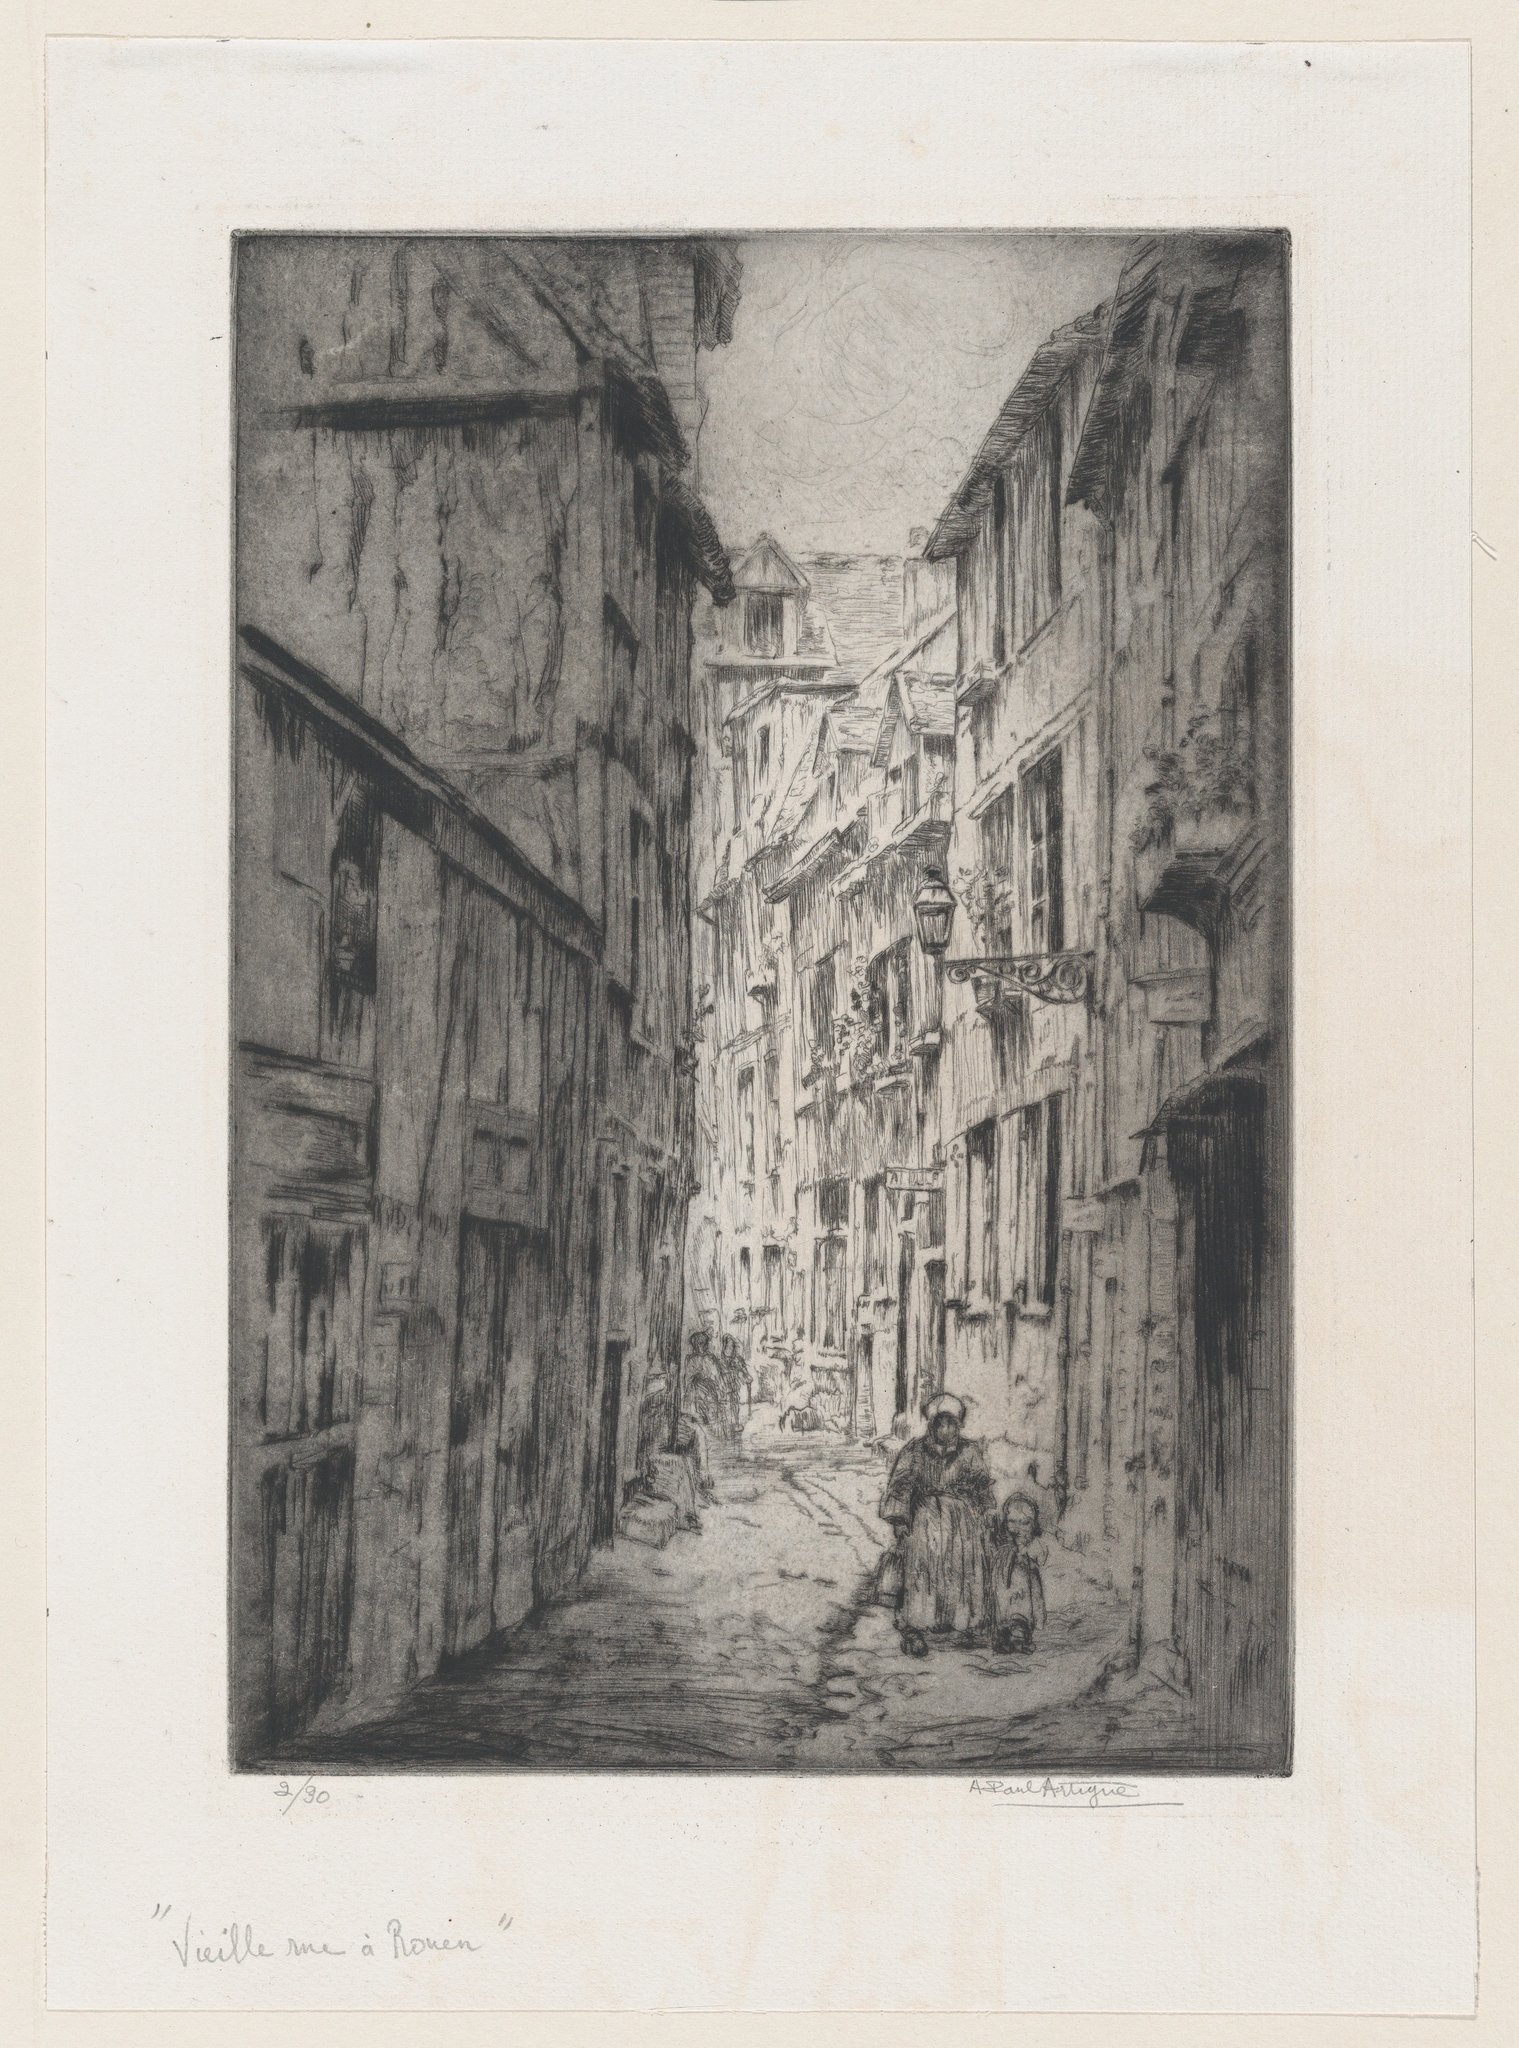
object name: print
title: Old Street in Rouen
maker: a. paul artigue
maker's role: artist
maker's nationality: french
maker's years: 1800-1900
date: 1801-1900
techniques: etching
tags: streets